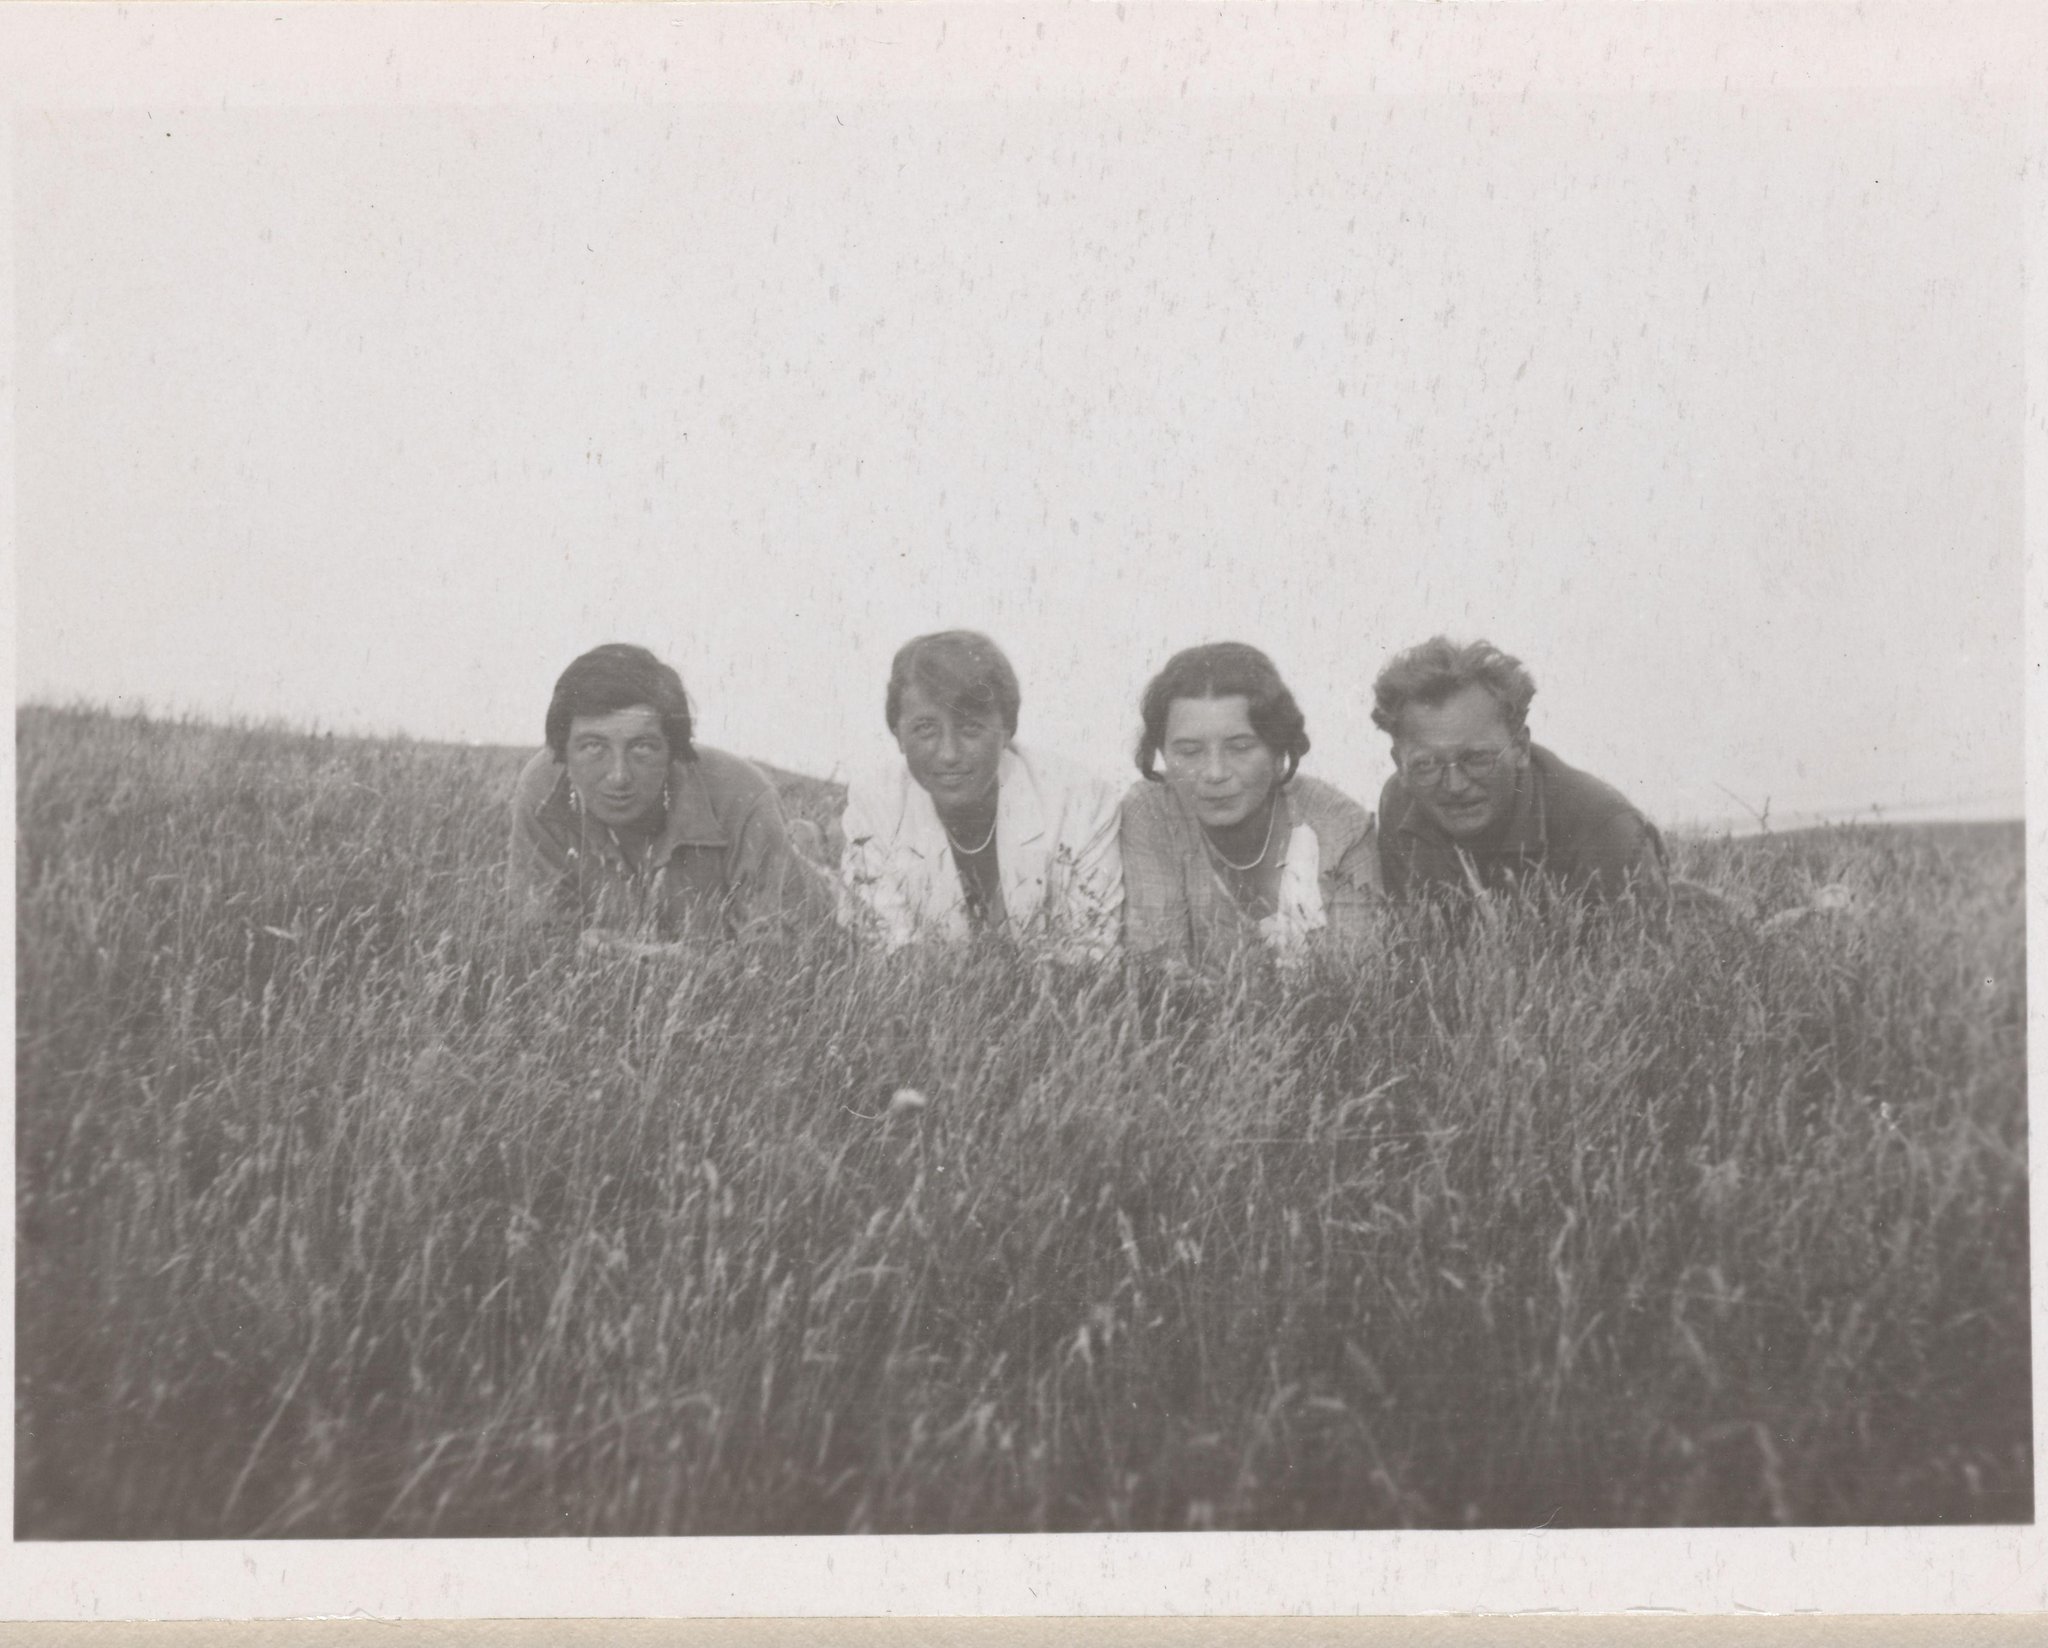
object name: photograph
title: Groepsportret van Karl With en drie onbekende vrouwen liggend in het gras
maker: Anonymous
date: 1920-1936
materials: paper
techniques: gelatin silver print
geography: germany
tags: karl with, historical persons, outdoor gathering, 'délices à la campagne', germany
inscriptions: number: ‘14’